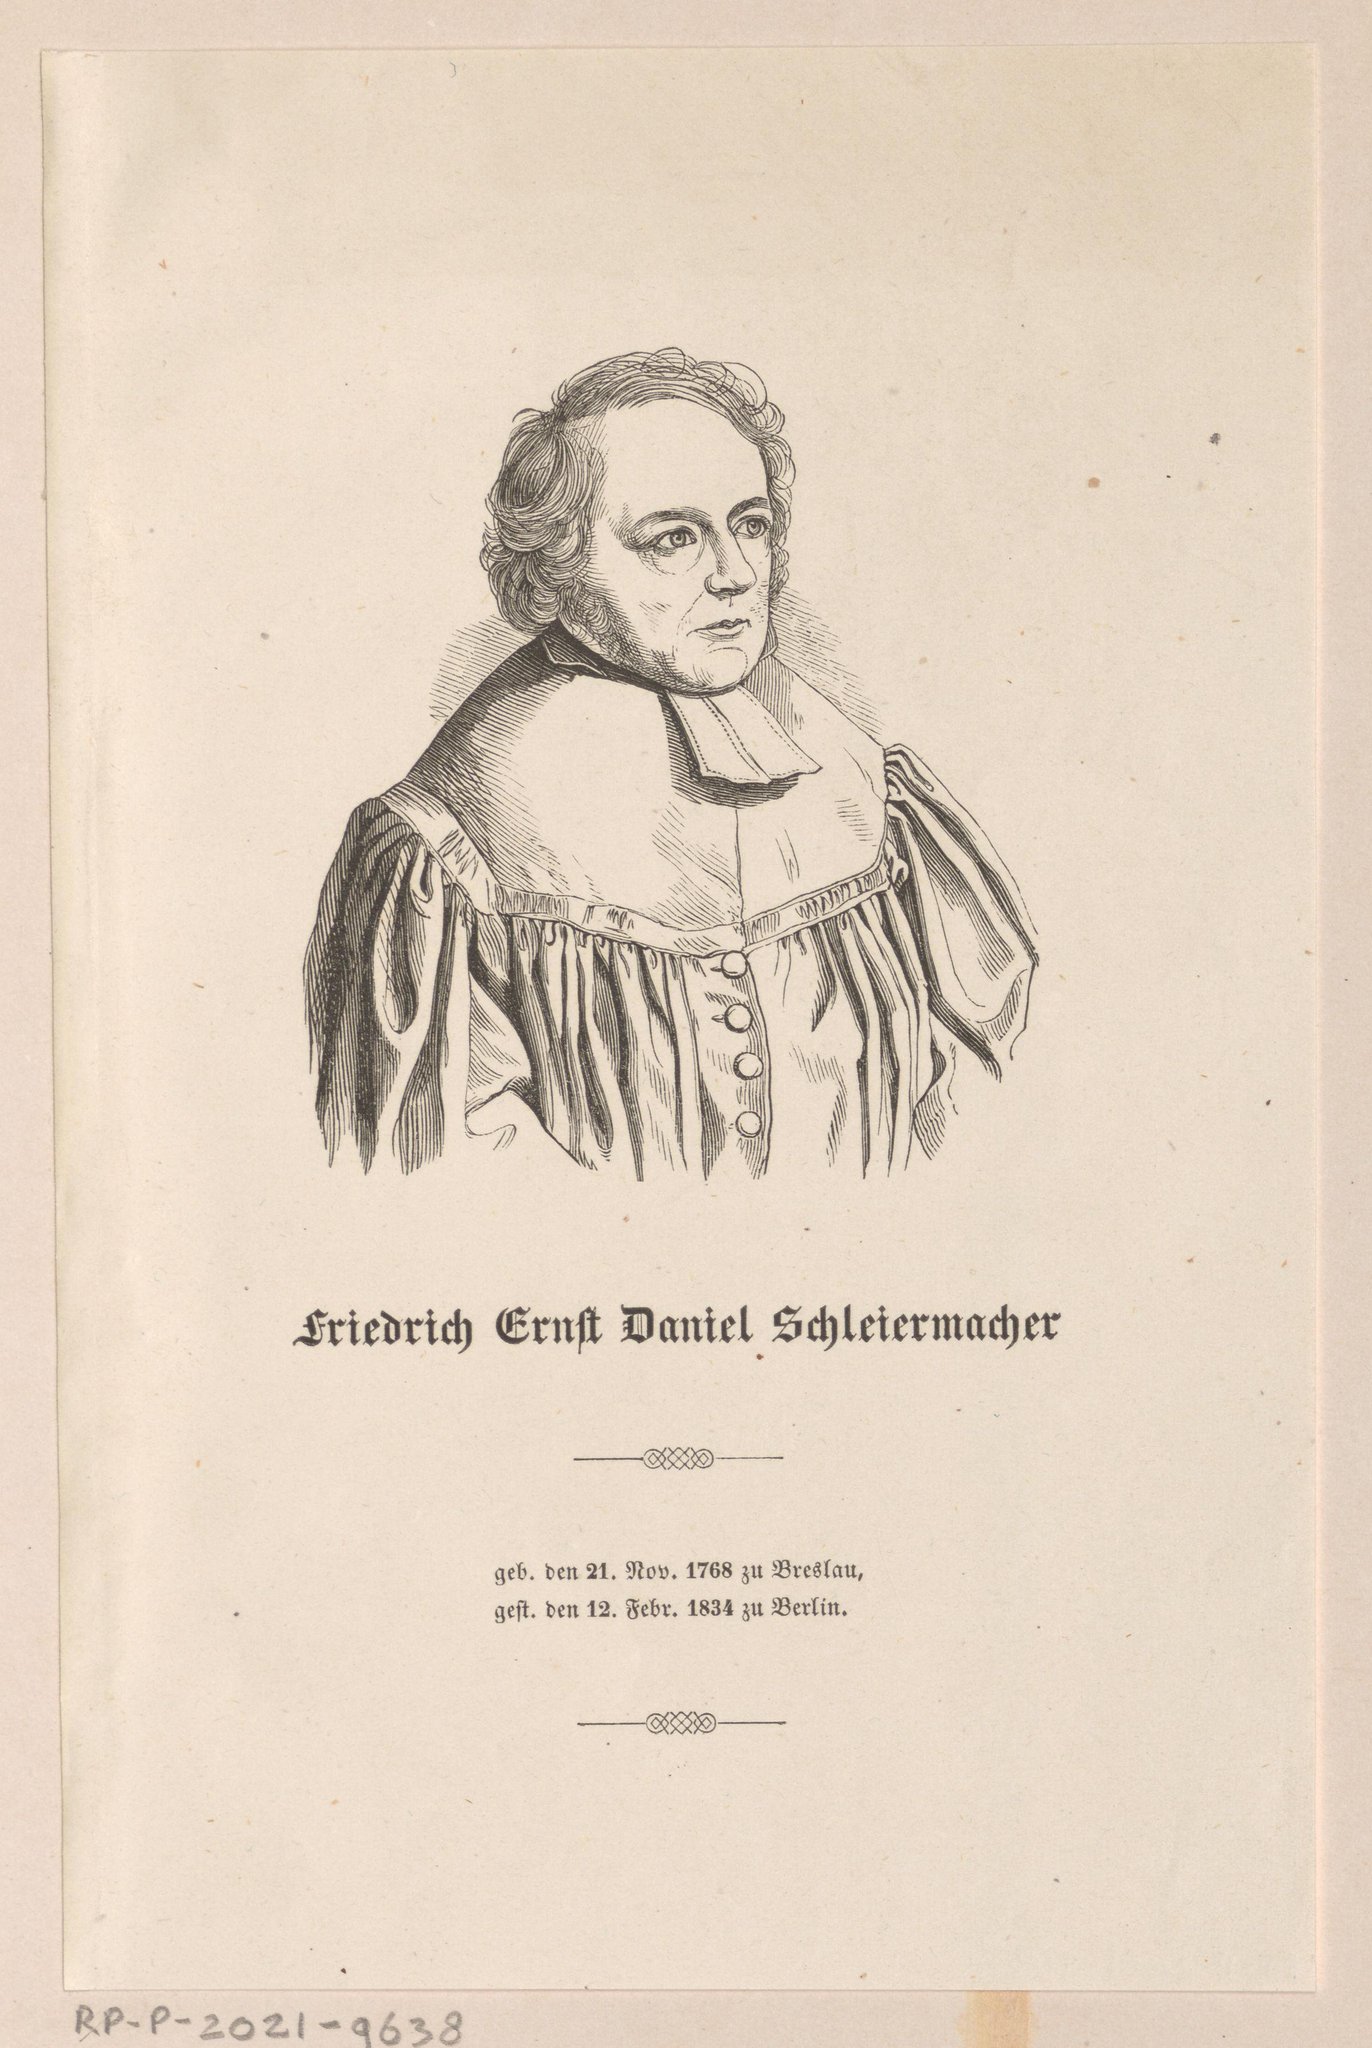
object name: print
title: Portret van Friedrich Ernst Daniel Schleiermacher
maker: Anonymous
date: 1854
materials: paper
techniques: engraving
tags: berlin, theologian, historical persons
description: Prent waarschijnlijk uit: Scherr, Johannes. Geschichte der Deutschen Literatur. Leipzig: Otto Wigand, 1854.